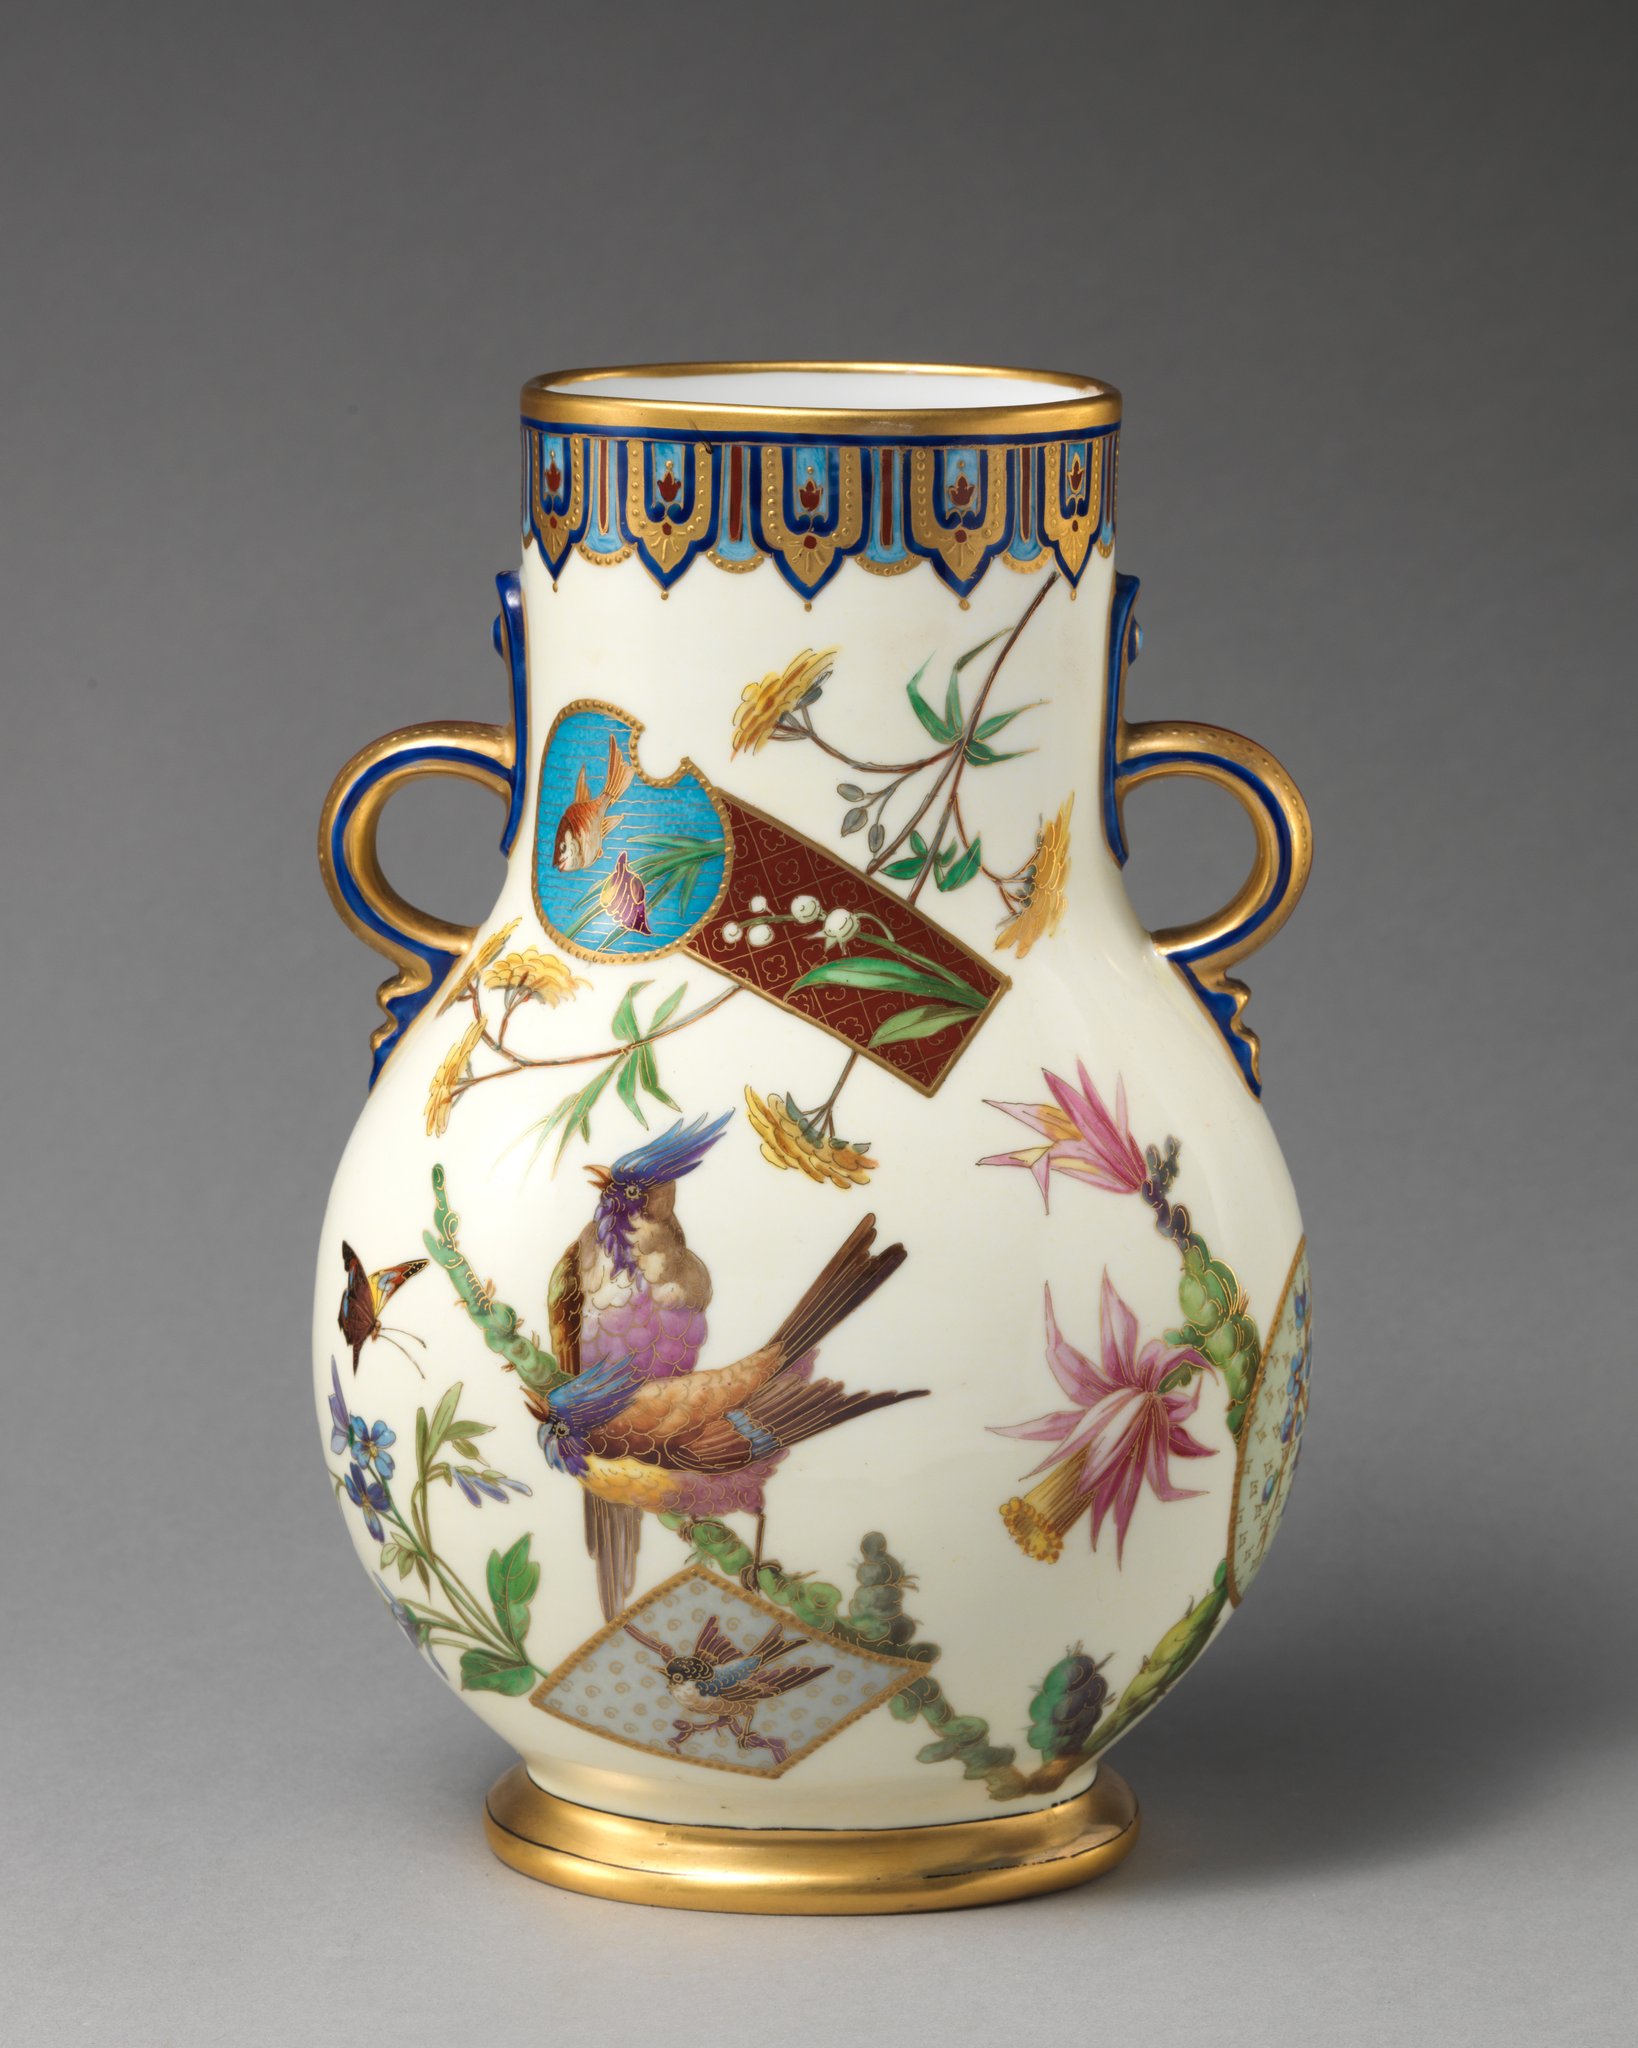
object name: vase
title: Vase with Aesthetic Japonisme birds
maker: minton(s)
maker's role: maker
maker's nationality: british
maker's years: 1793-2001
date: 1879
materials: bone china